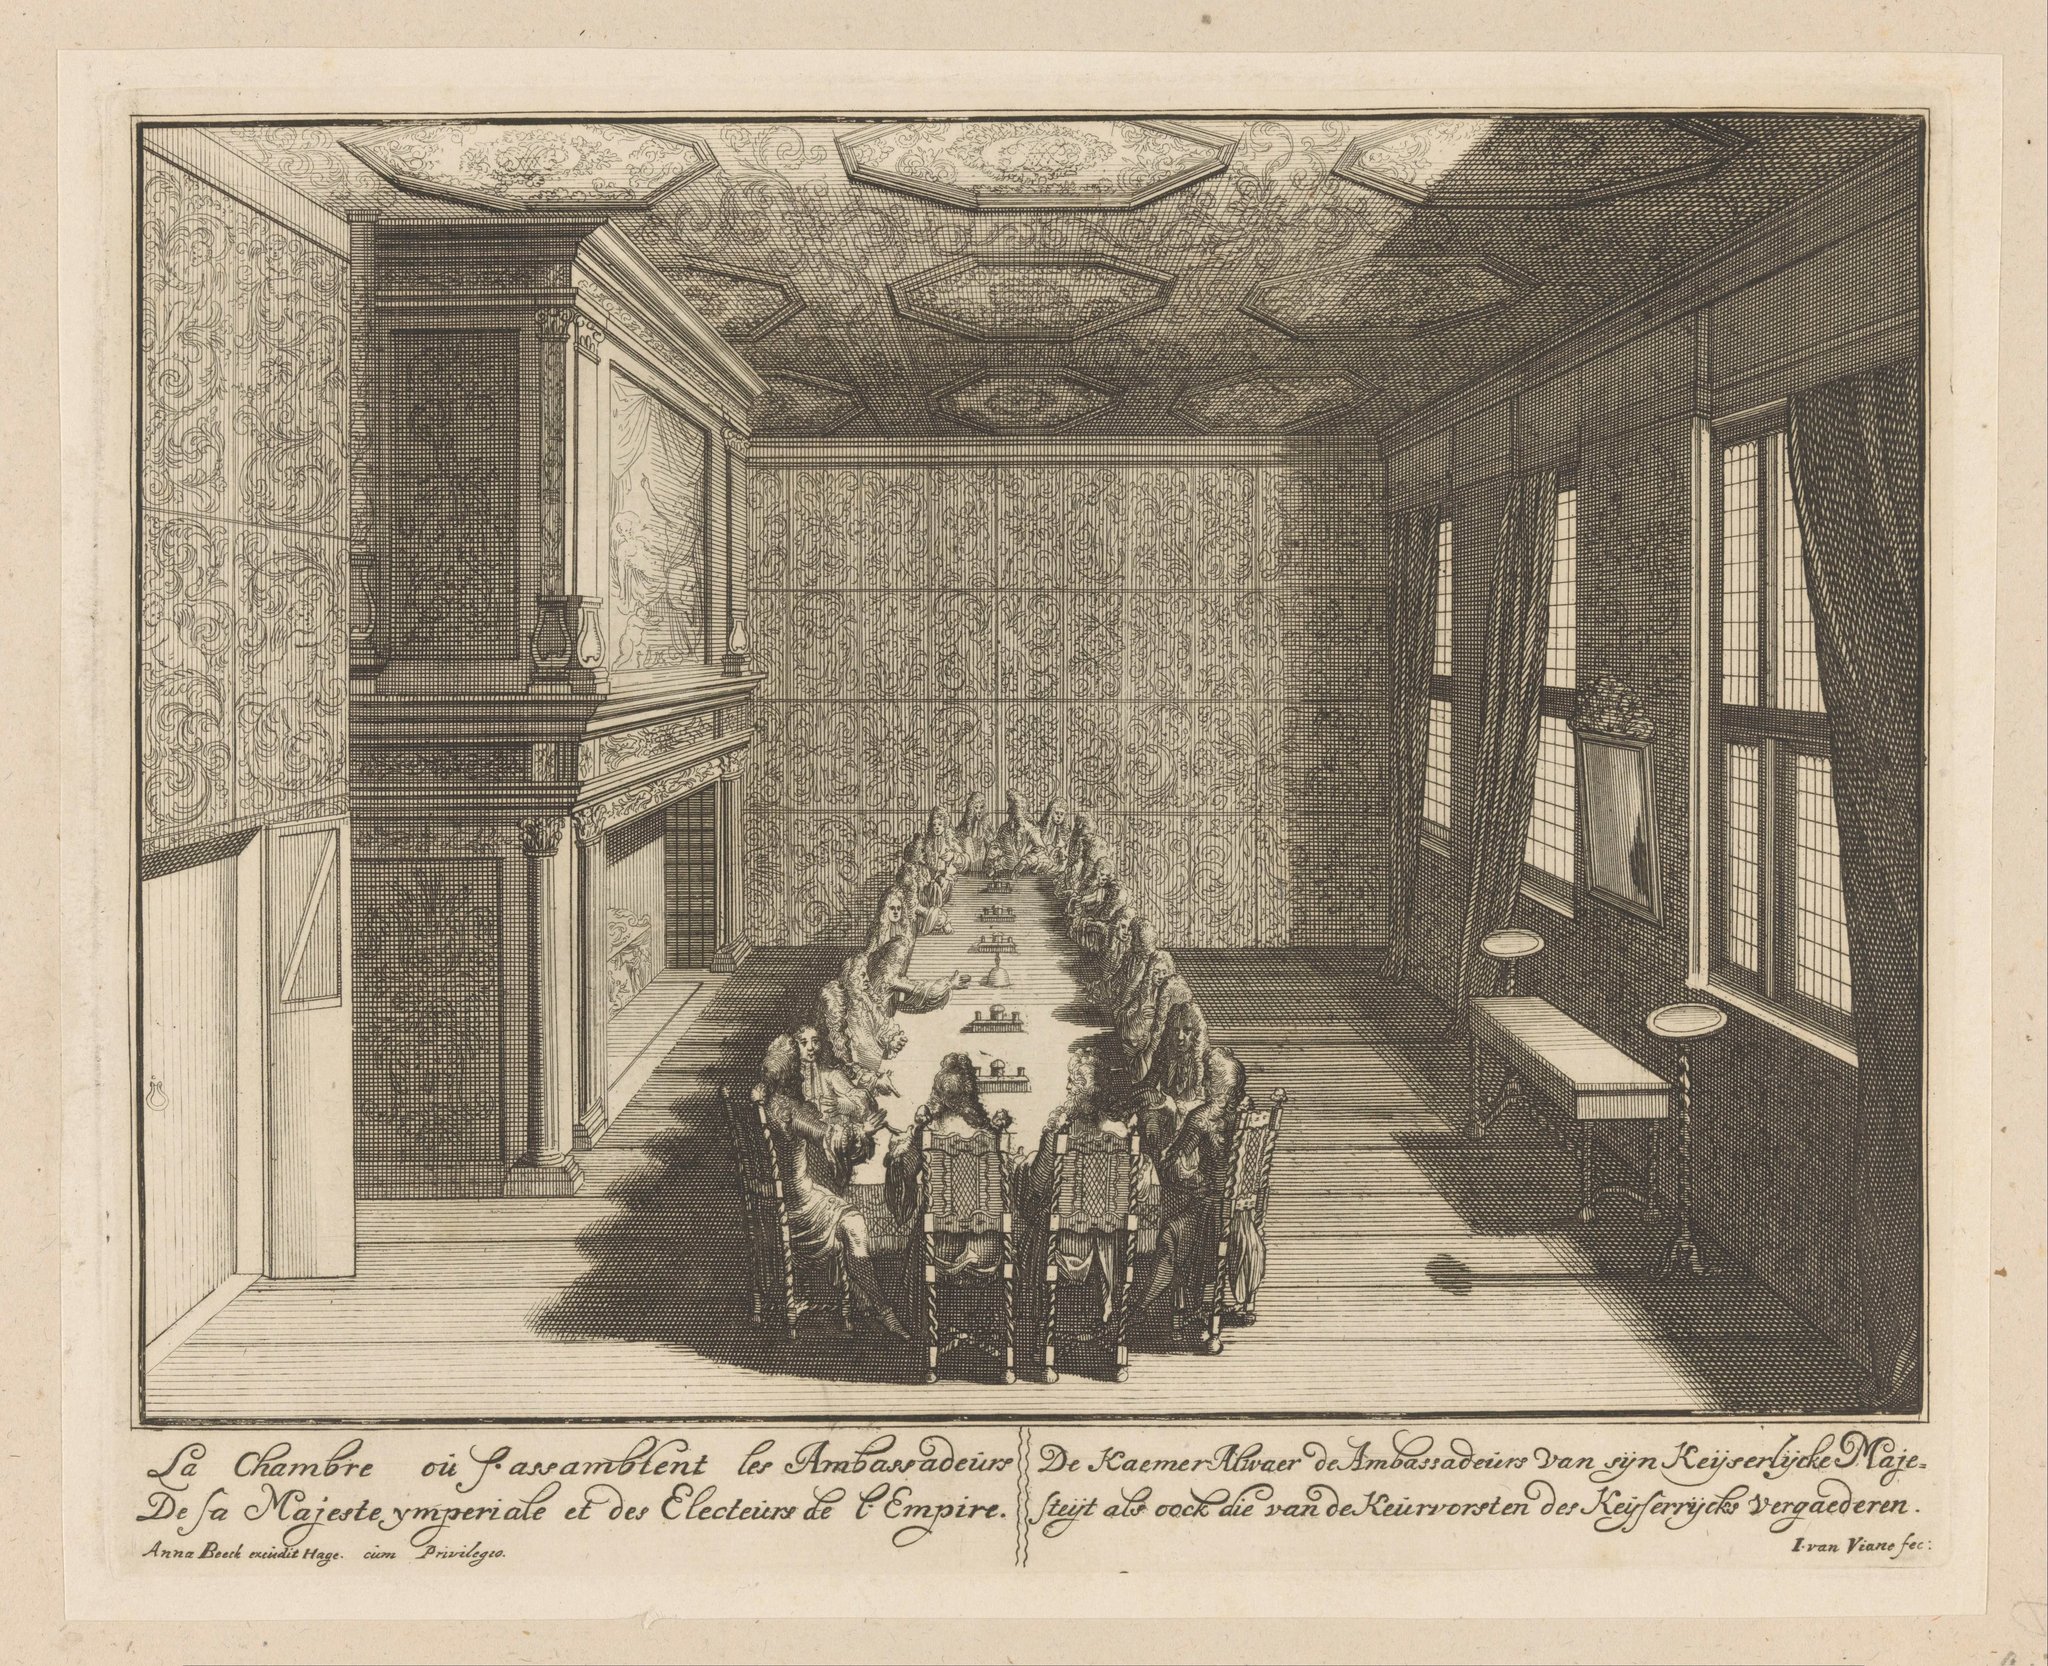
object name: print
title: Le Château Roial de Ryswick Appellée de Neubourg avec les differens apartemens ou se tiennent les Conferenes de la Paix Generale / Het Koninglyke Kasteel tot Ryswyck, Genaamt Nieuwburg, met alle des selfs Kamers en gezigten, in 't bysonder, daar de Conferentien der algemeene Vreede gehouden werden, &c.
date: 1697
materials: paper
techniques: etching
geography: northern netherlands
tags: palace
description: Kamer van de ambassadeurs van de keizer en de keurvorsten in het Huis ter Nieuburch in Rijswijk. Een groep mannen vergaderend aan een lange tafel. In het onderschrift de twee titels in het Frans en Nederlands. Onderdeel (prent 10) van de serie van vijftien prenten over het Huis ter Nieuburch in Rijswijk en de daar gehouden vredesonderhandelingen resulterend in de Vrede van Rijswijk gesloten op 20 september 1697.